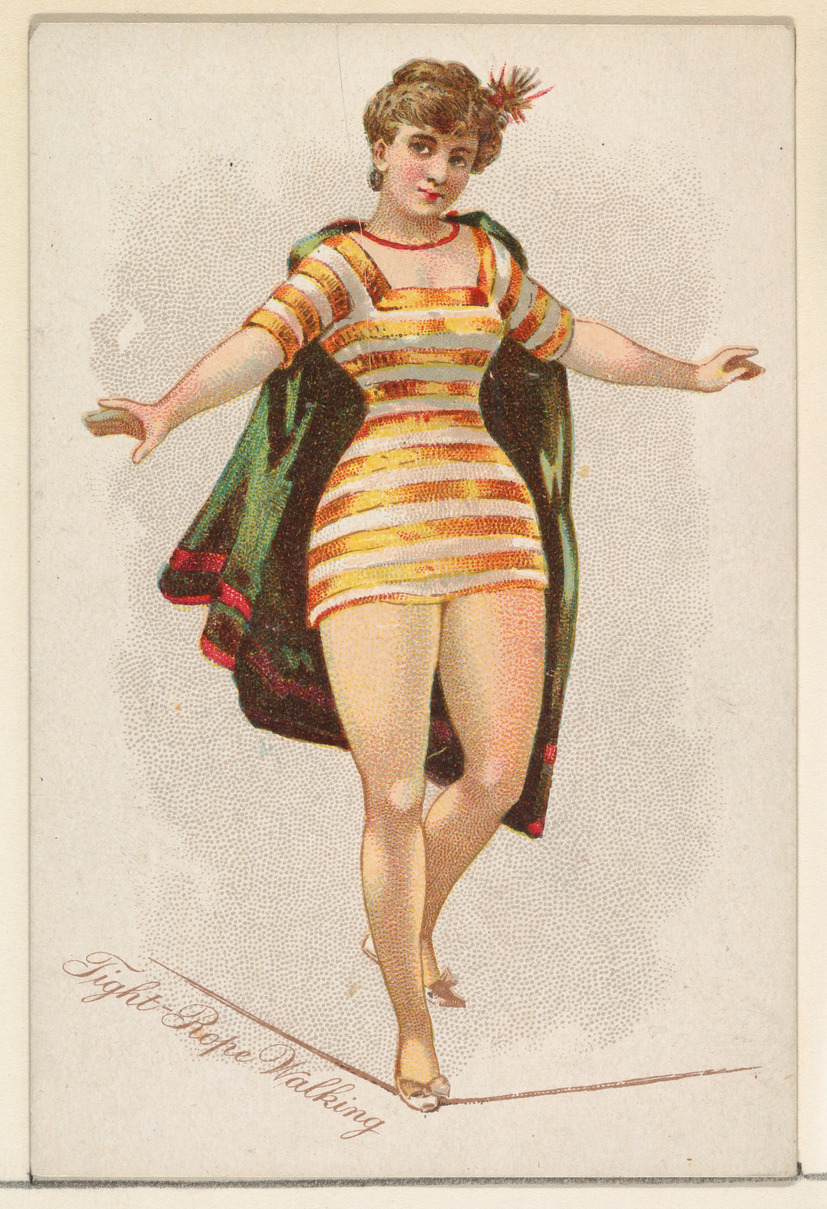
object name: print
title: Tightrope Walking, from the Pretty Athletes series (N196) issued by Wm. S. Kimball & Co.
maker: william s. kimball & company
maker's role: publisher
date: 1889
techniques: color lithograph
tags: women,athletes